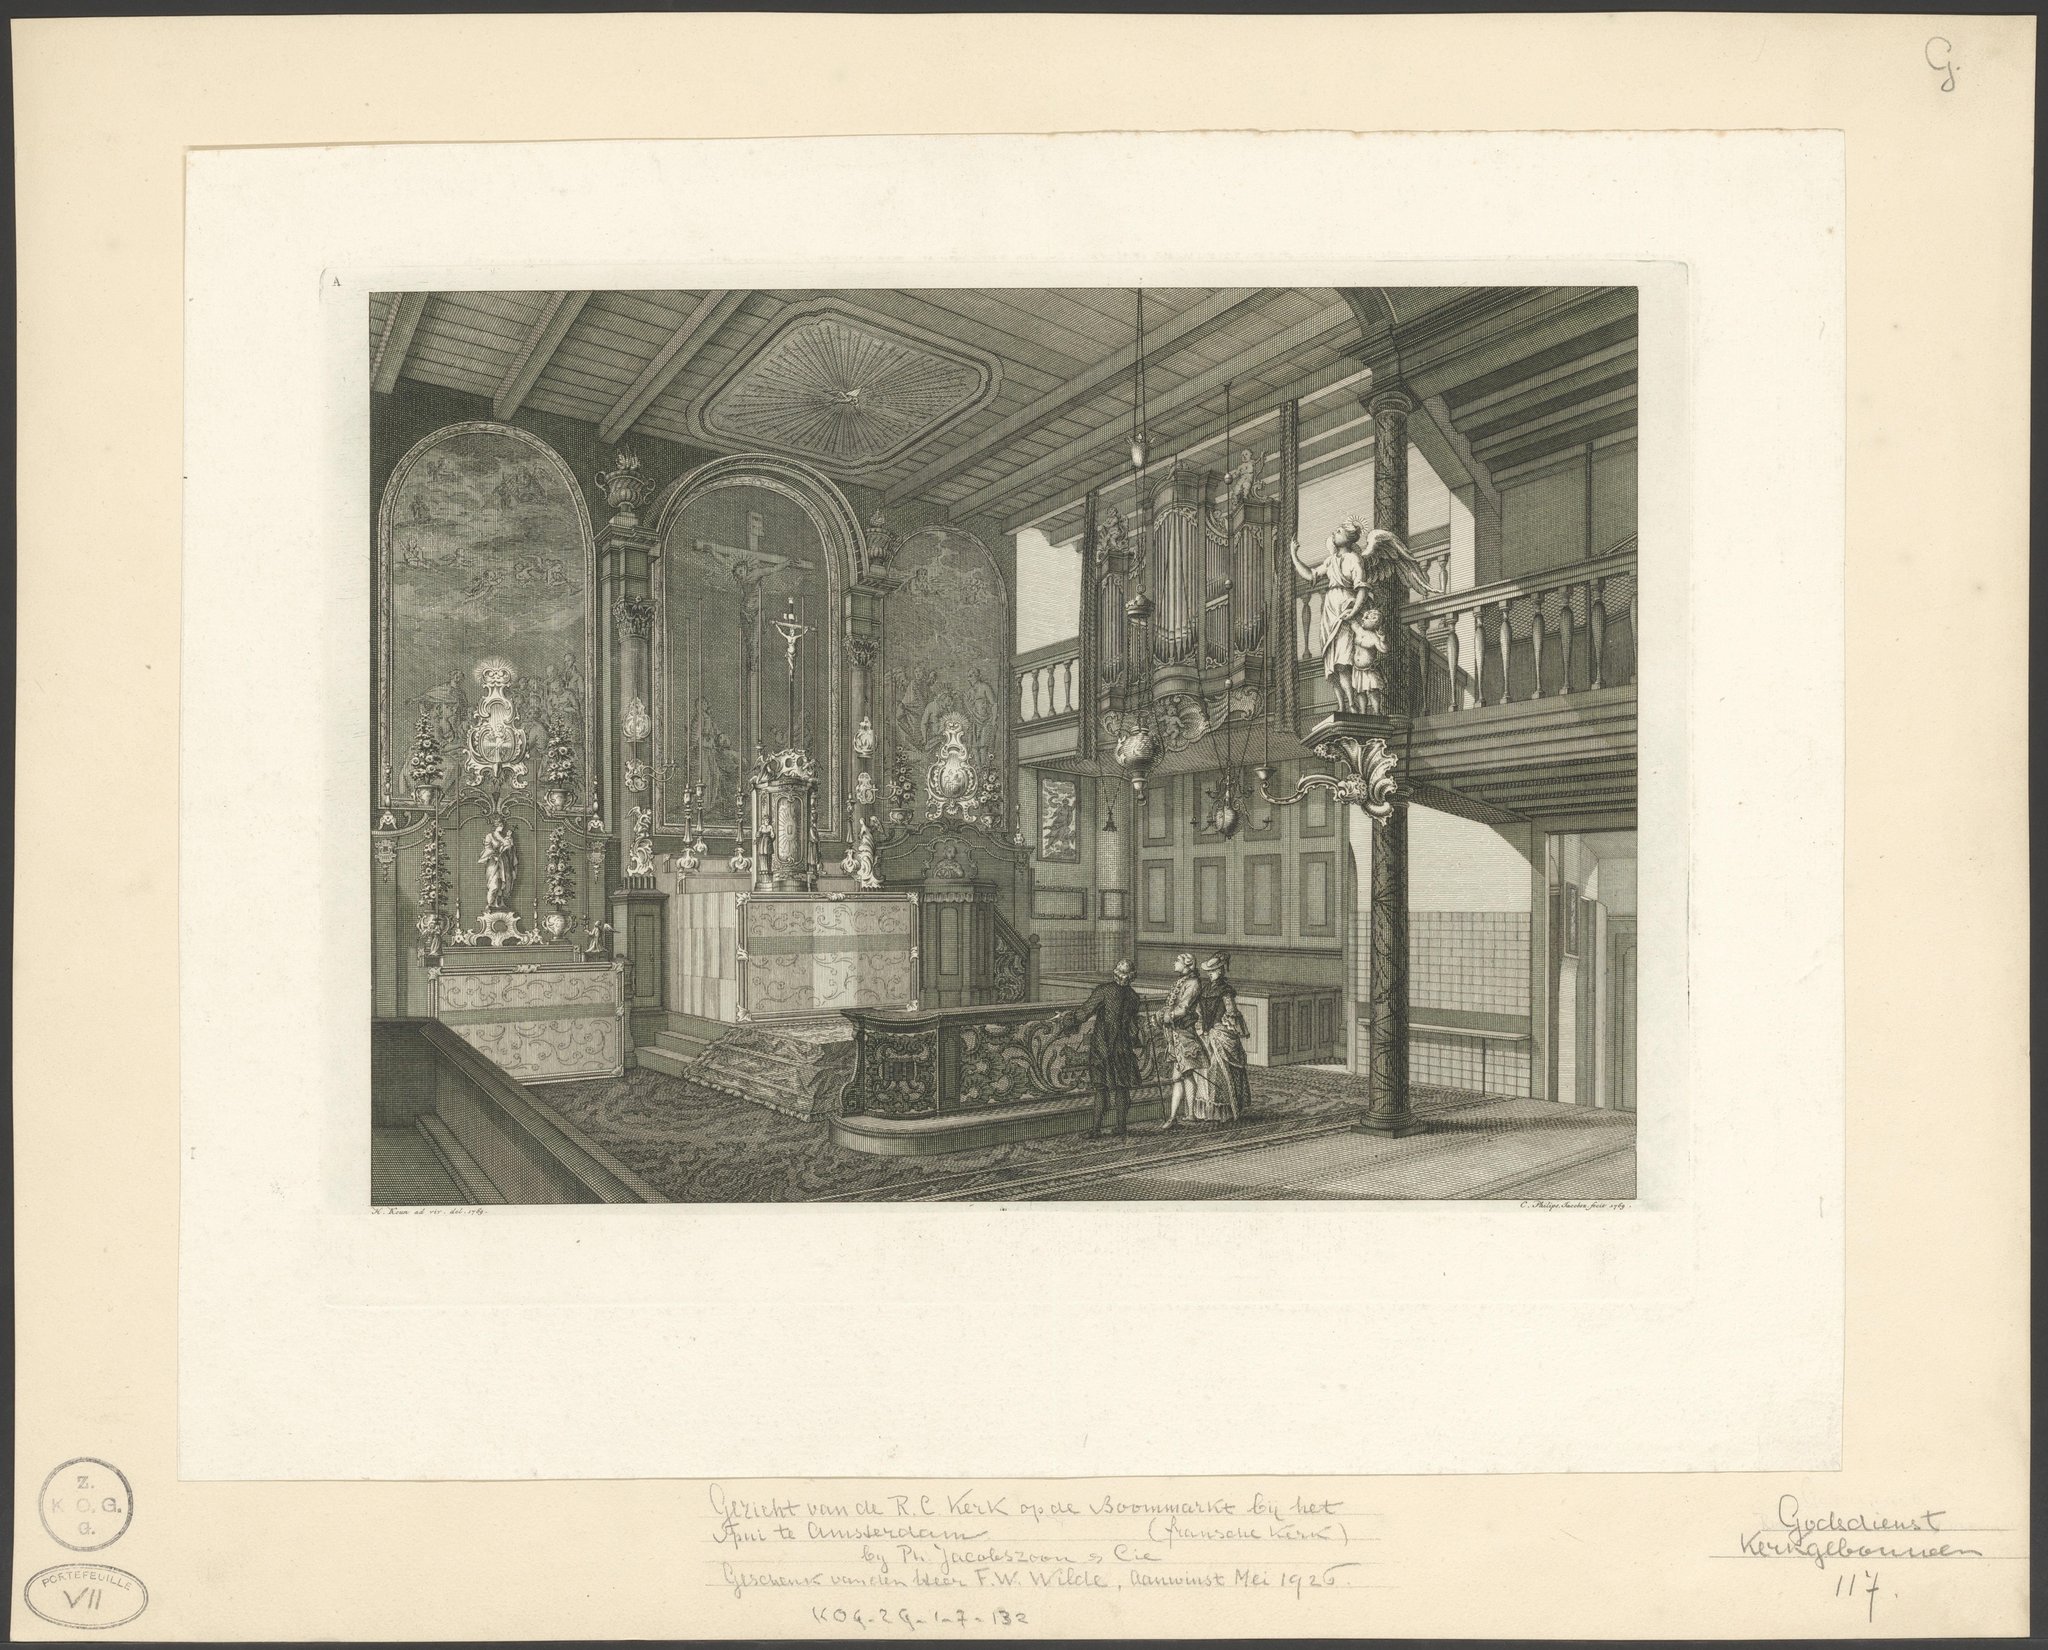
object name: print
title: Interieur van de Rooms Katholieke schuilkerk op de Boommarkt te Amsterdam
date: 1769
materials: paper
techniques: etching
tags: interior of church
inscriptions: stamp, collector's mark: Lugt 1641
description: Linksboven genummerd: A. Onderwerpsrubrieken binnen de Atlas Zeden en Gewoonten: Godsdienst, Kerkgebouwen te Amsterdam.